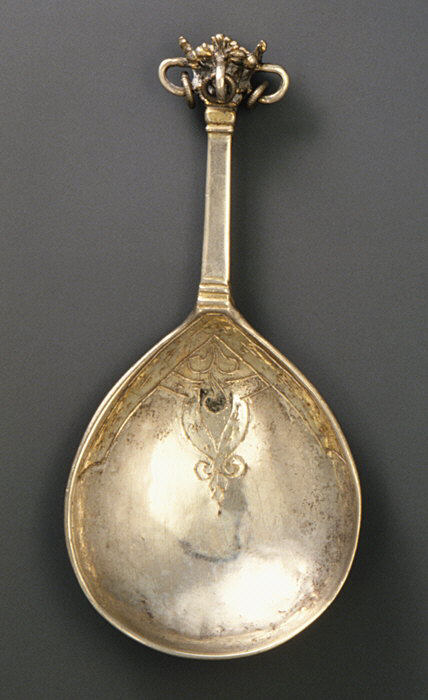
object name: spoon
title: Crown-top spoon (one of three)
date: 1501-1600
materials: gilt, silver